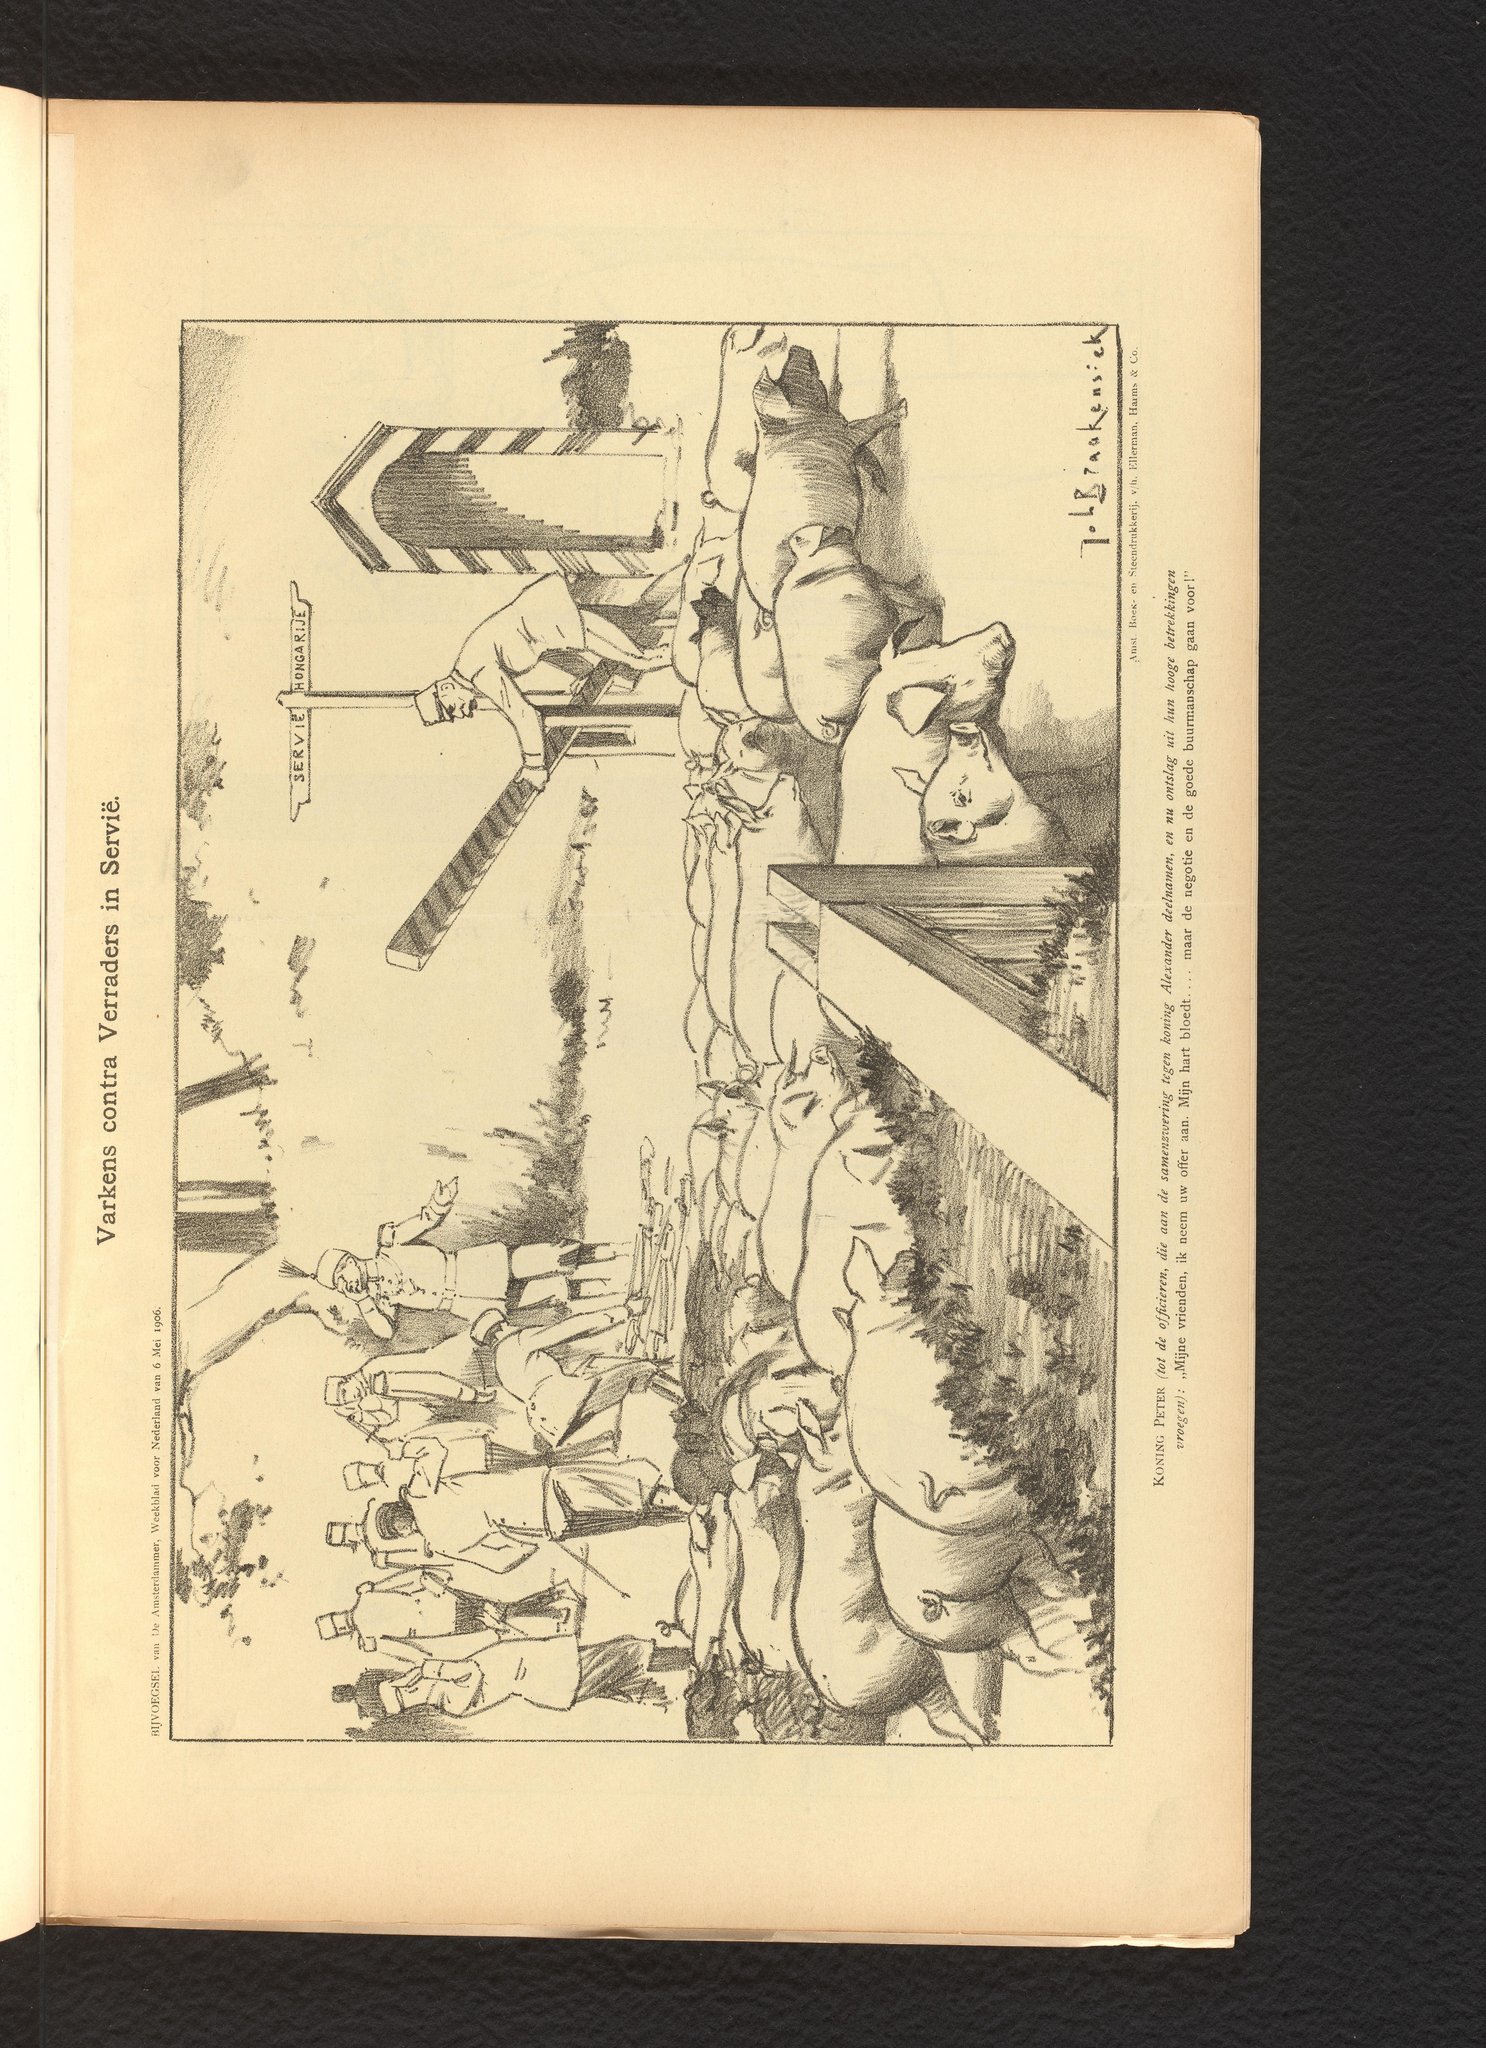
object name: cartoon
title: Varkens contra Verraders in Servië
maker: johan braakensiek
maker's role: draughtsman, print maker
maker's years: 1858-1940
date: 1906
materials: paper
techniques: lithograph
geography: amsterdam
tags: pig, customs, political caricatures and satires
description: Koning Peter van Servië laat de varkens en de officieren die in 1903 de staatsgreep tegen koning Alexander pleegden over de grens naar Hongarije gaan.